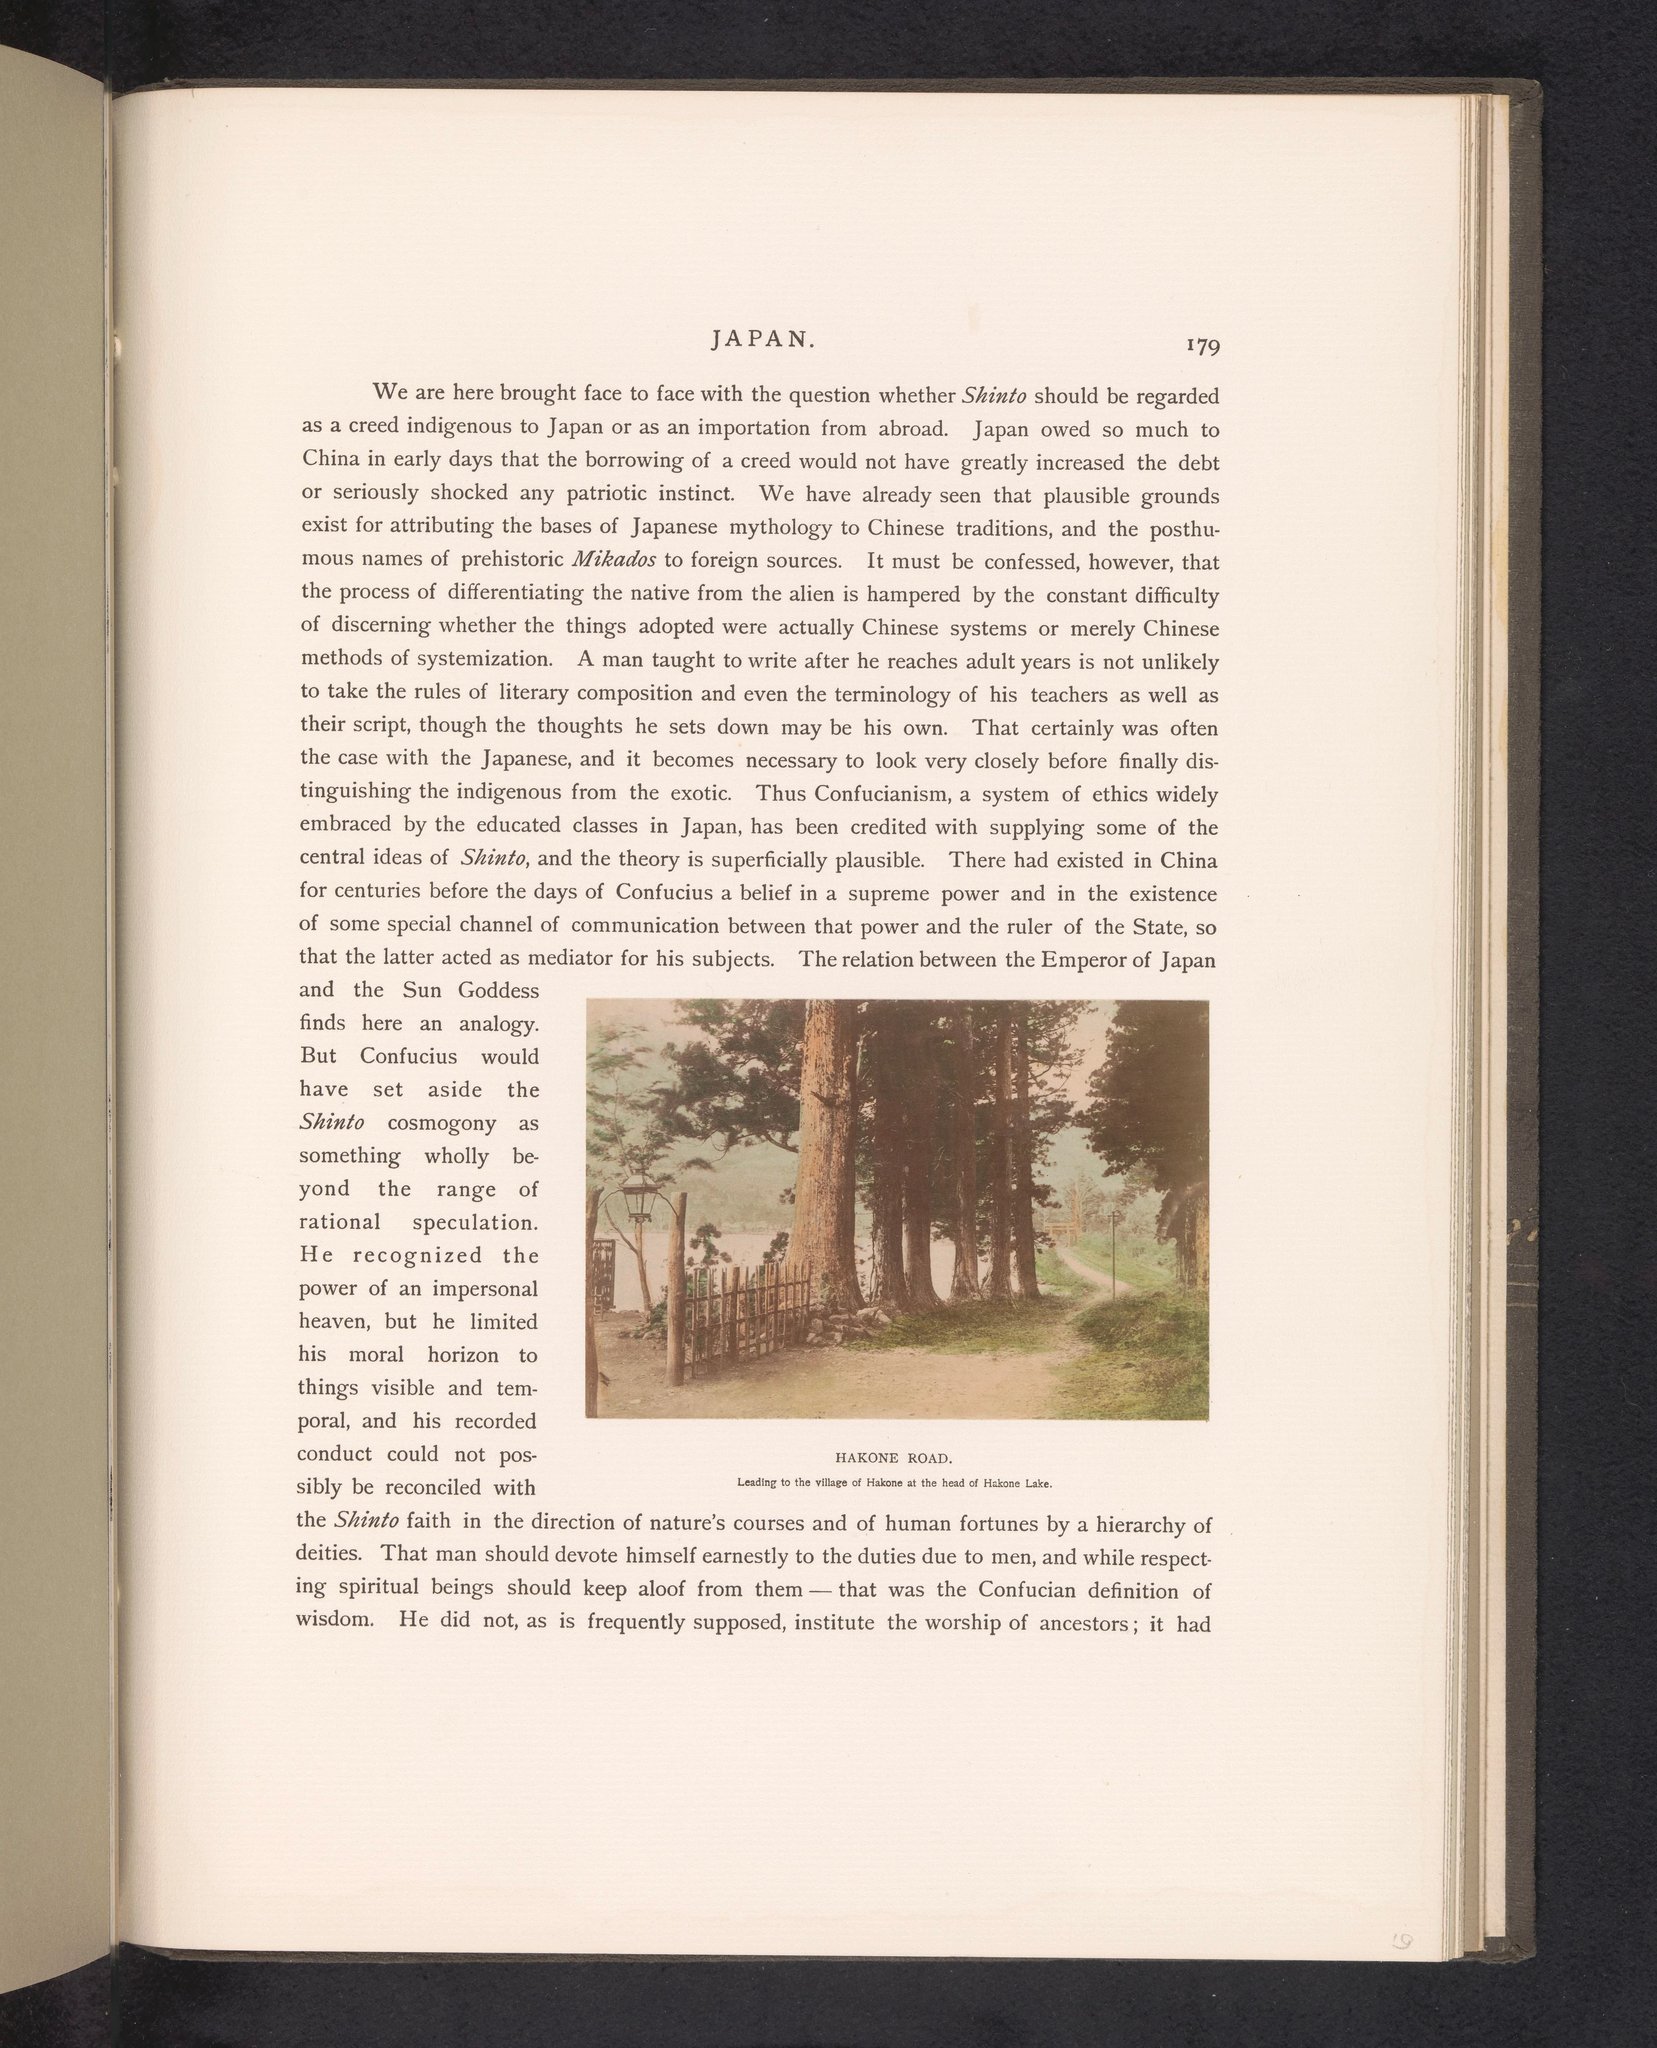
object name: page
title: Hakone road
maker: Anonymous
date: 1887-1897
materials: photographic support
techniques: albumen print, hand coloring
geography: kanagawa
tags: forest path or lane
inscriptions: inscription: ‘Leading to the village of Hakone at the head of Hakone Lake.’